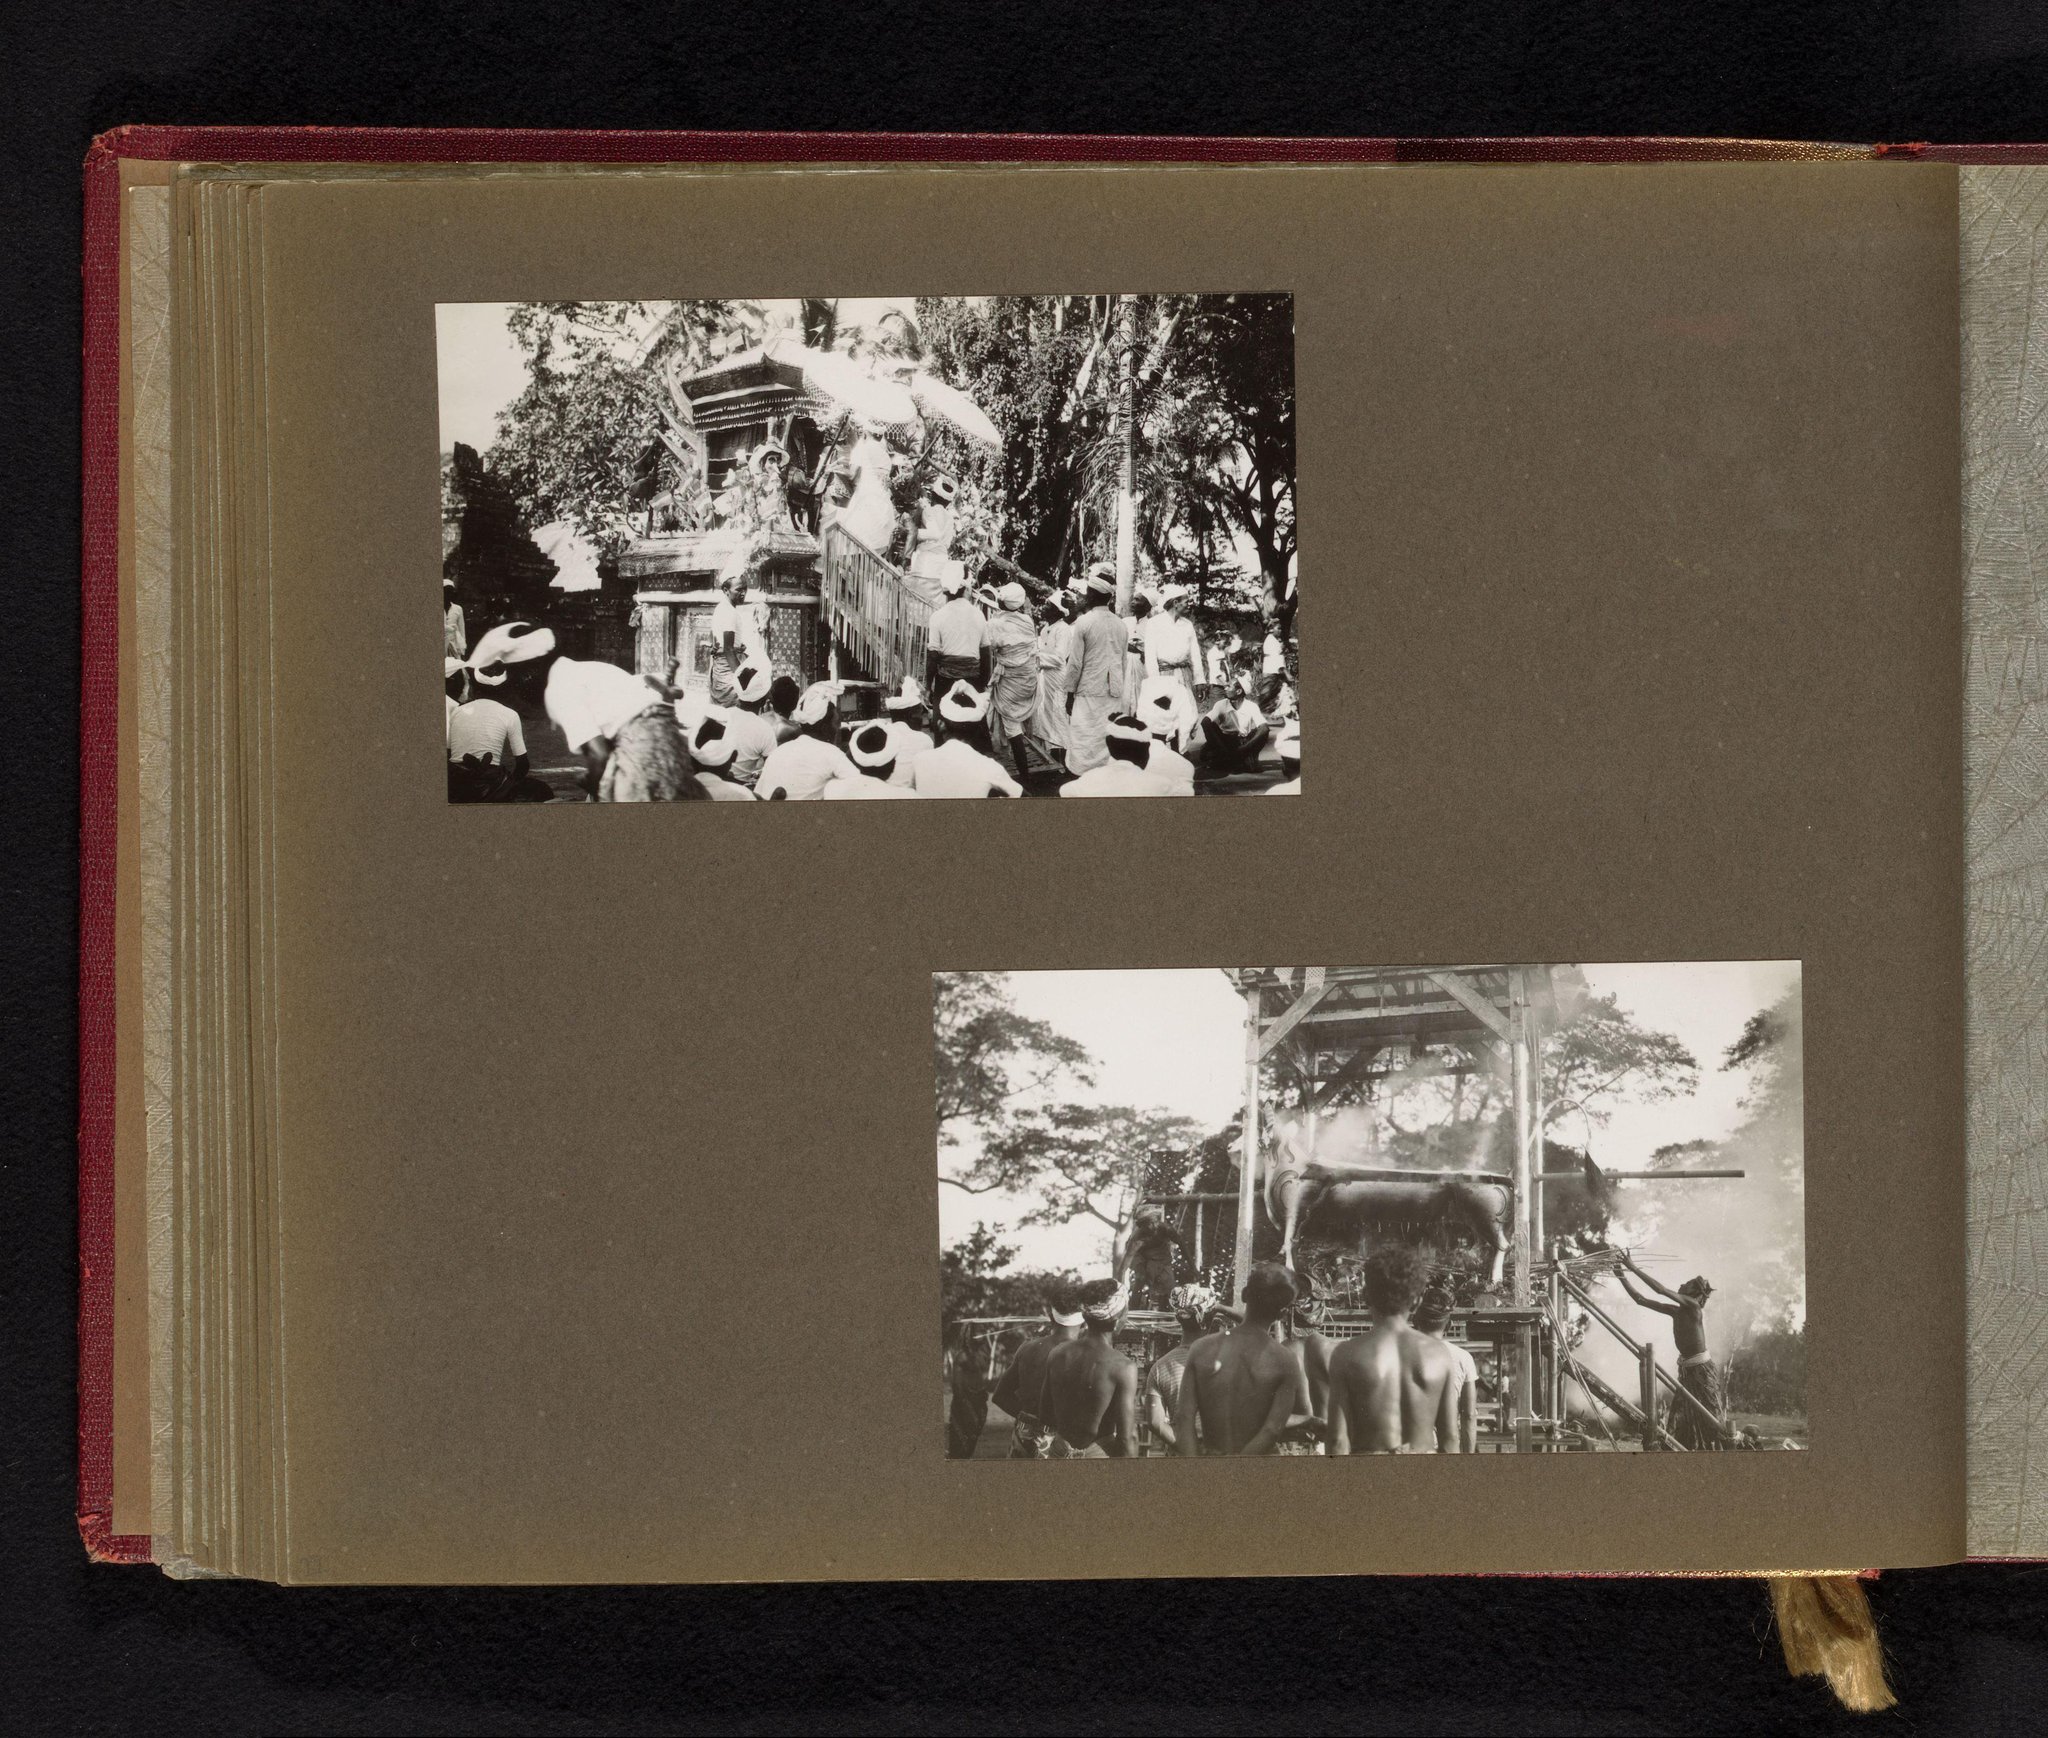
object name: photograph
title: Twee opnamen van rituele gebruiken, mogelijk rond een uitvaart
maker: Anonymous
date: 1950-1960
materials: photographic support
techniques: gelatin silver print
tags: ritual practices ~ non-christian religions, historical persons, dutch east indies, the